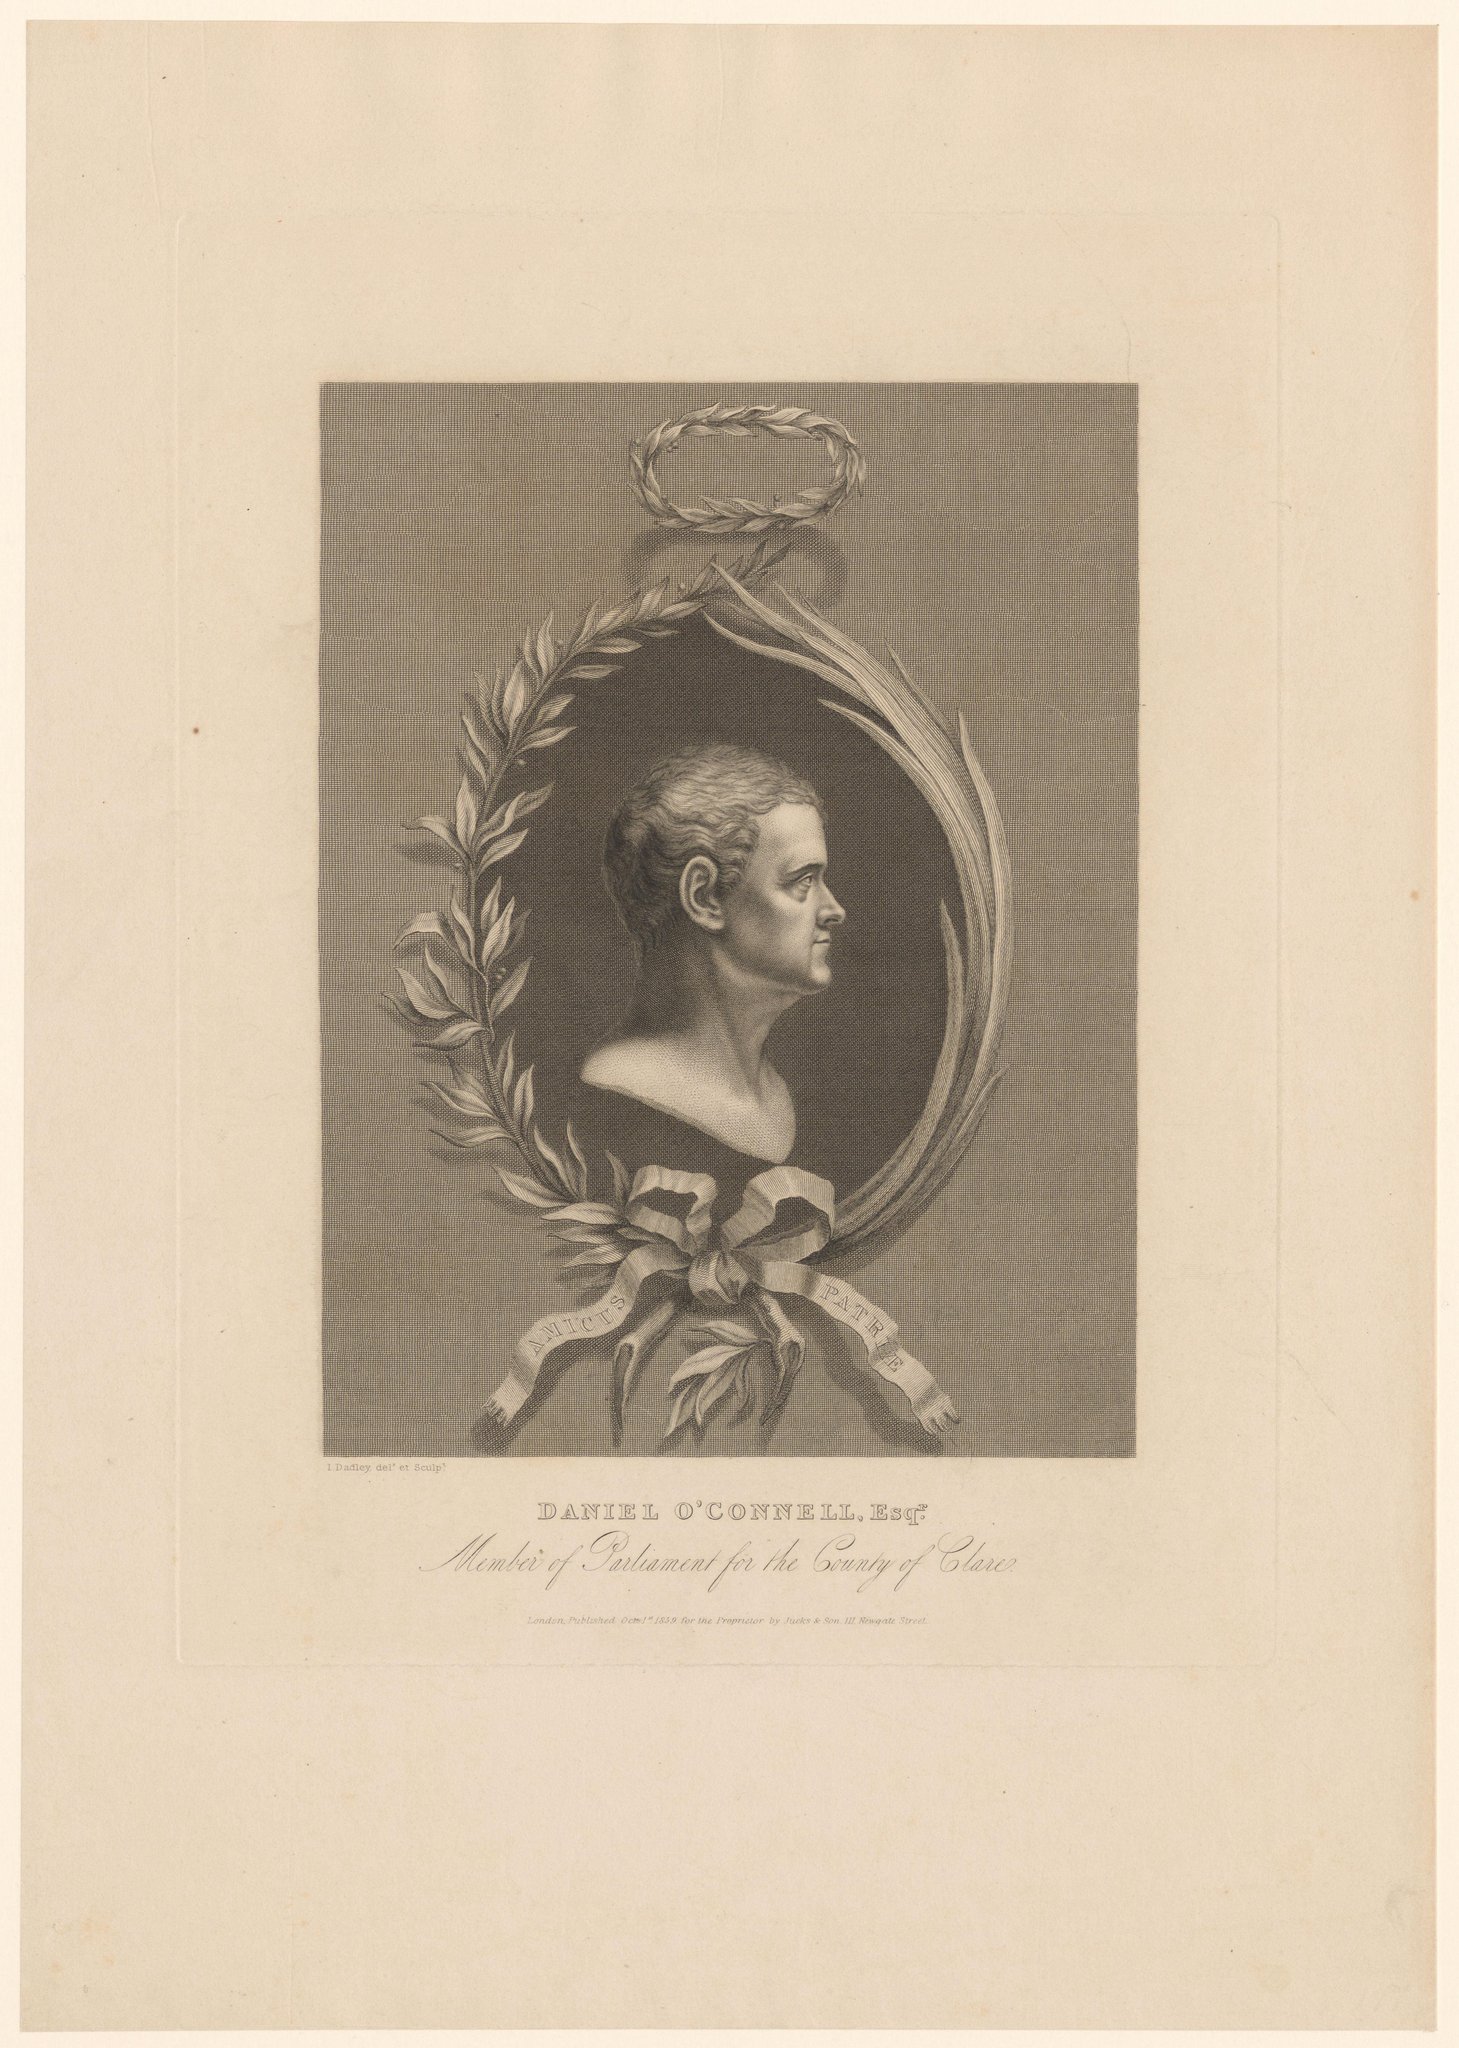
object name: print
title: Portret van Daniel O'Connell Esqr.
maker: john dadley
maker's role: print maker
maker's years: 1767-1817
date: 1839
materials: paper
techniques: engraving, etching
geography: london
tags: historical persons, politician, e.g. party leader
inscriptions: collector's mark: Lugt 2228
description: Omlijsting van palm en olijfbladen met een lauwerkrans bovenaan.